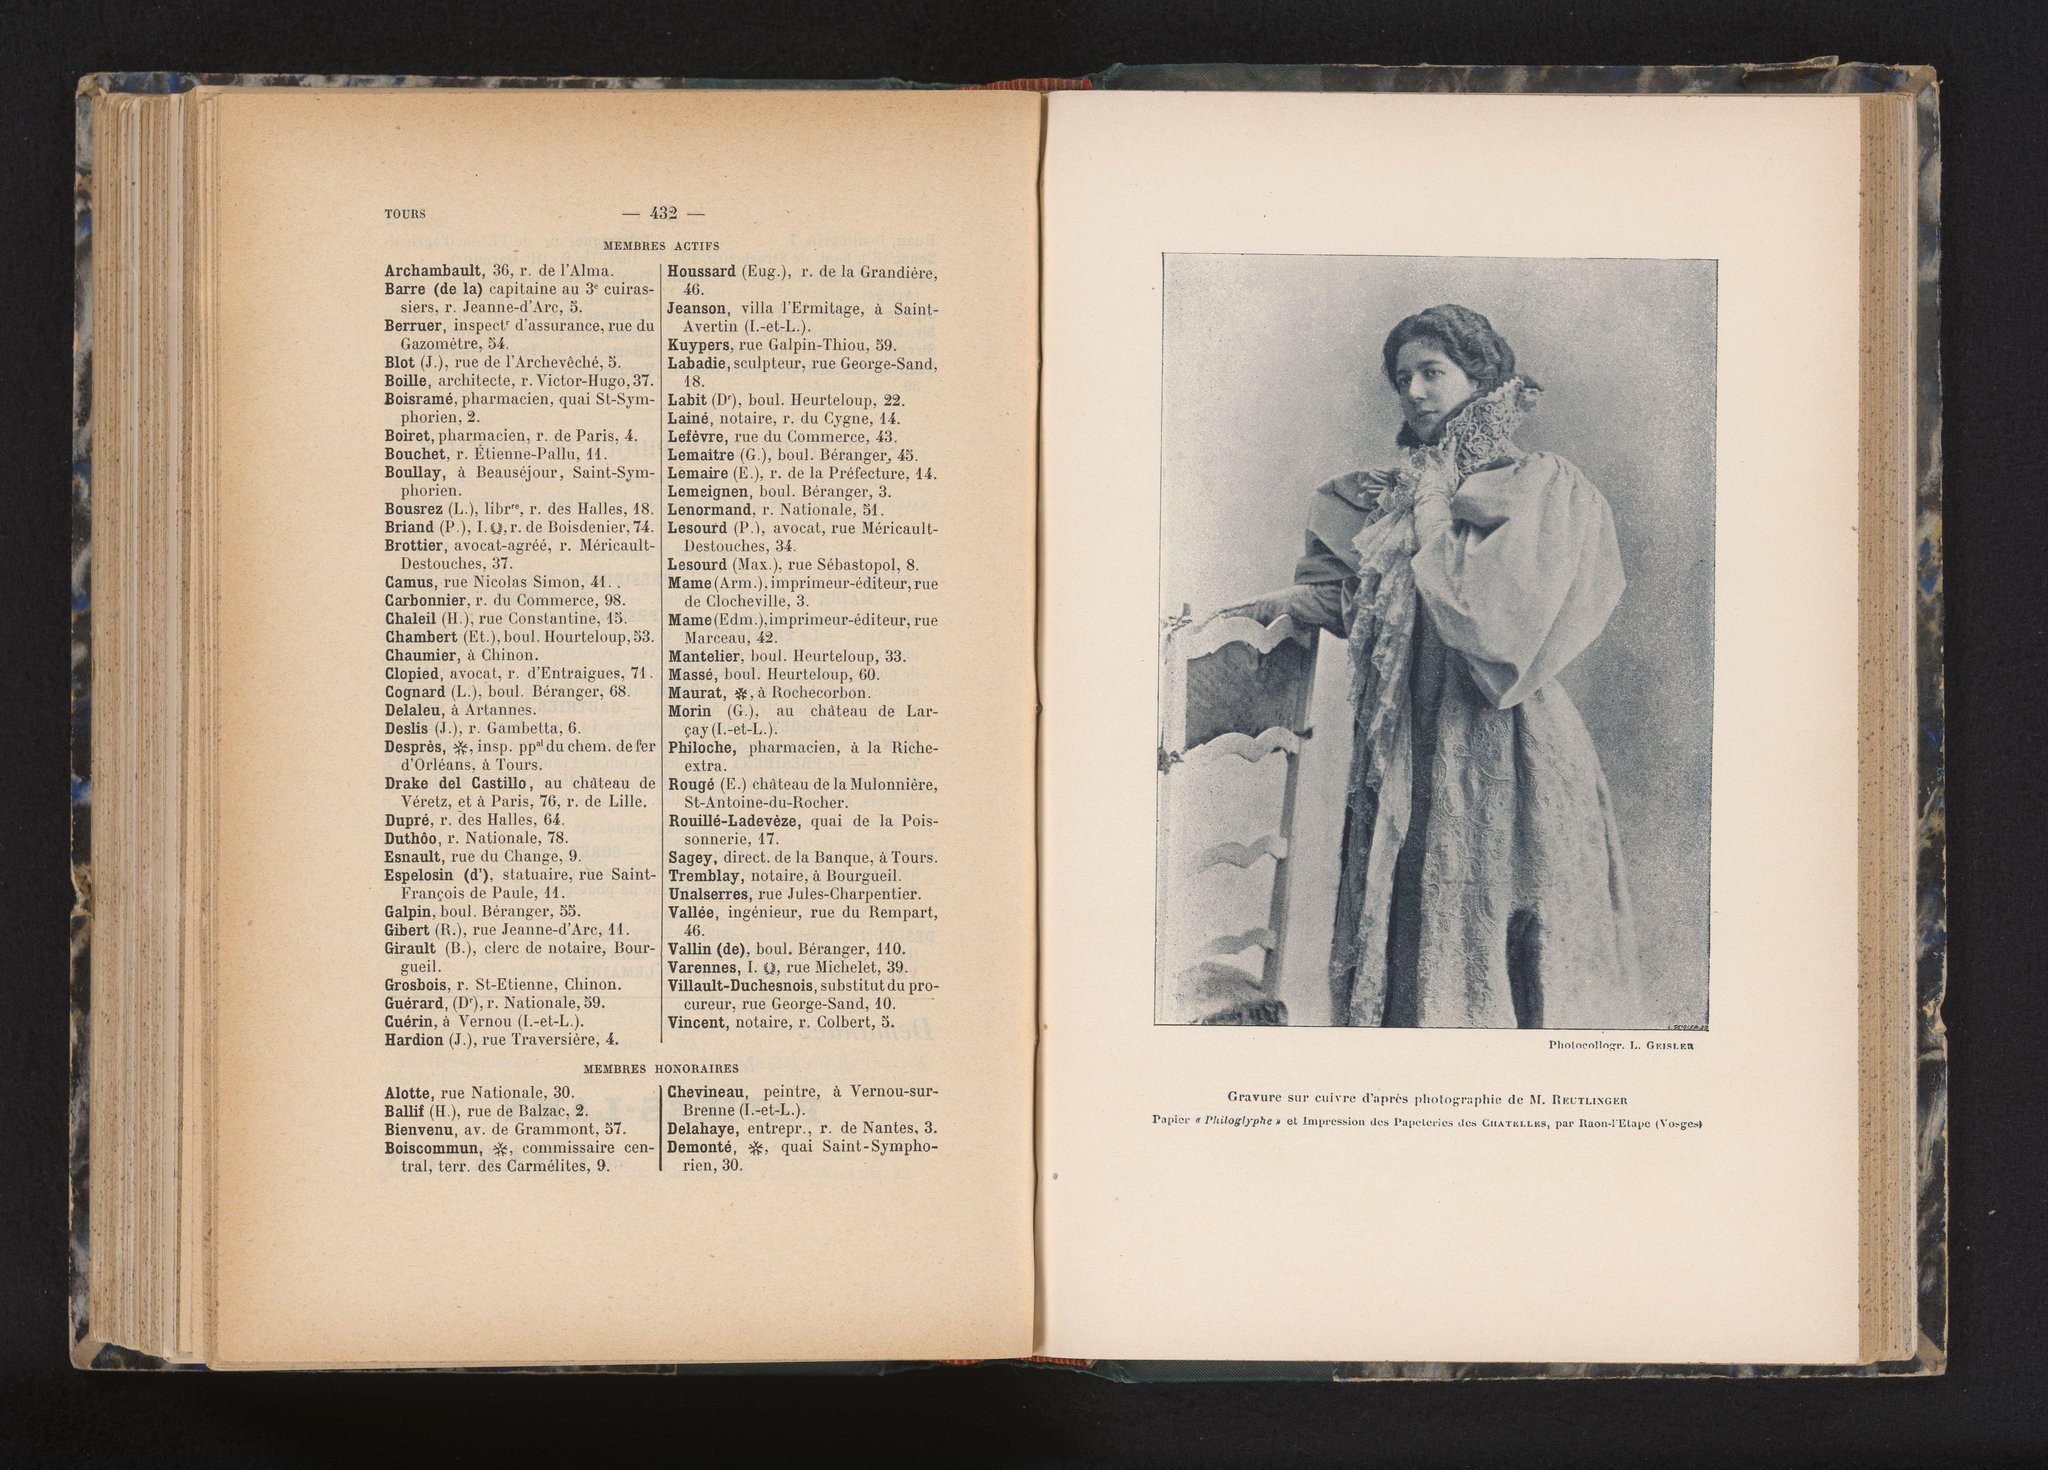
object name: photomechanical print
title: Portret van een onbekende vrouw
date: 1891-1896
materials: paper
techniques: autotype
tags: historical persons - bb - woman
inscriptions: inscription: ‘Gravure sur cuivre d'après photographie de M. Reutlinger/ Papier < Philoglyphe > et Impression des Papeteries des Chatelles, par Raon-l'Etape (Vosges)’